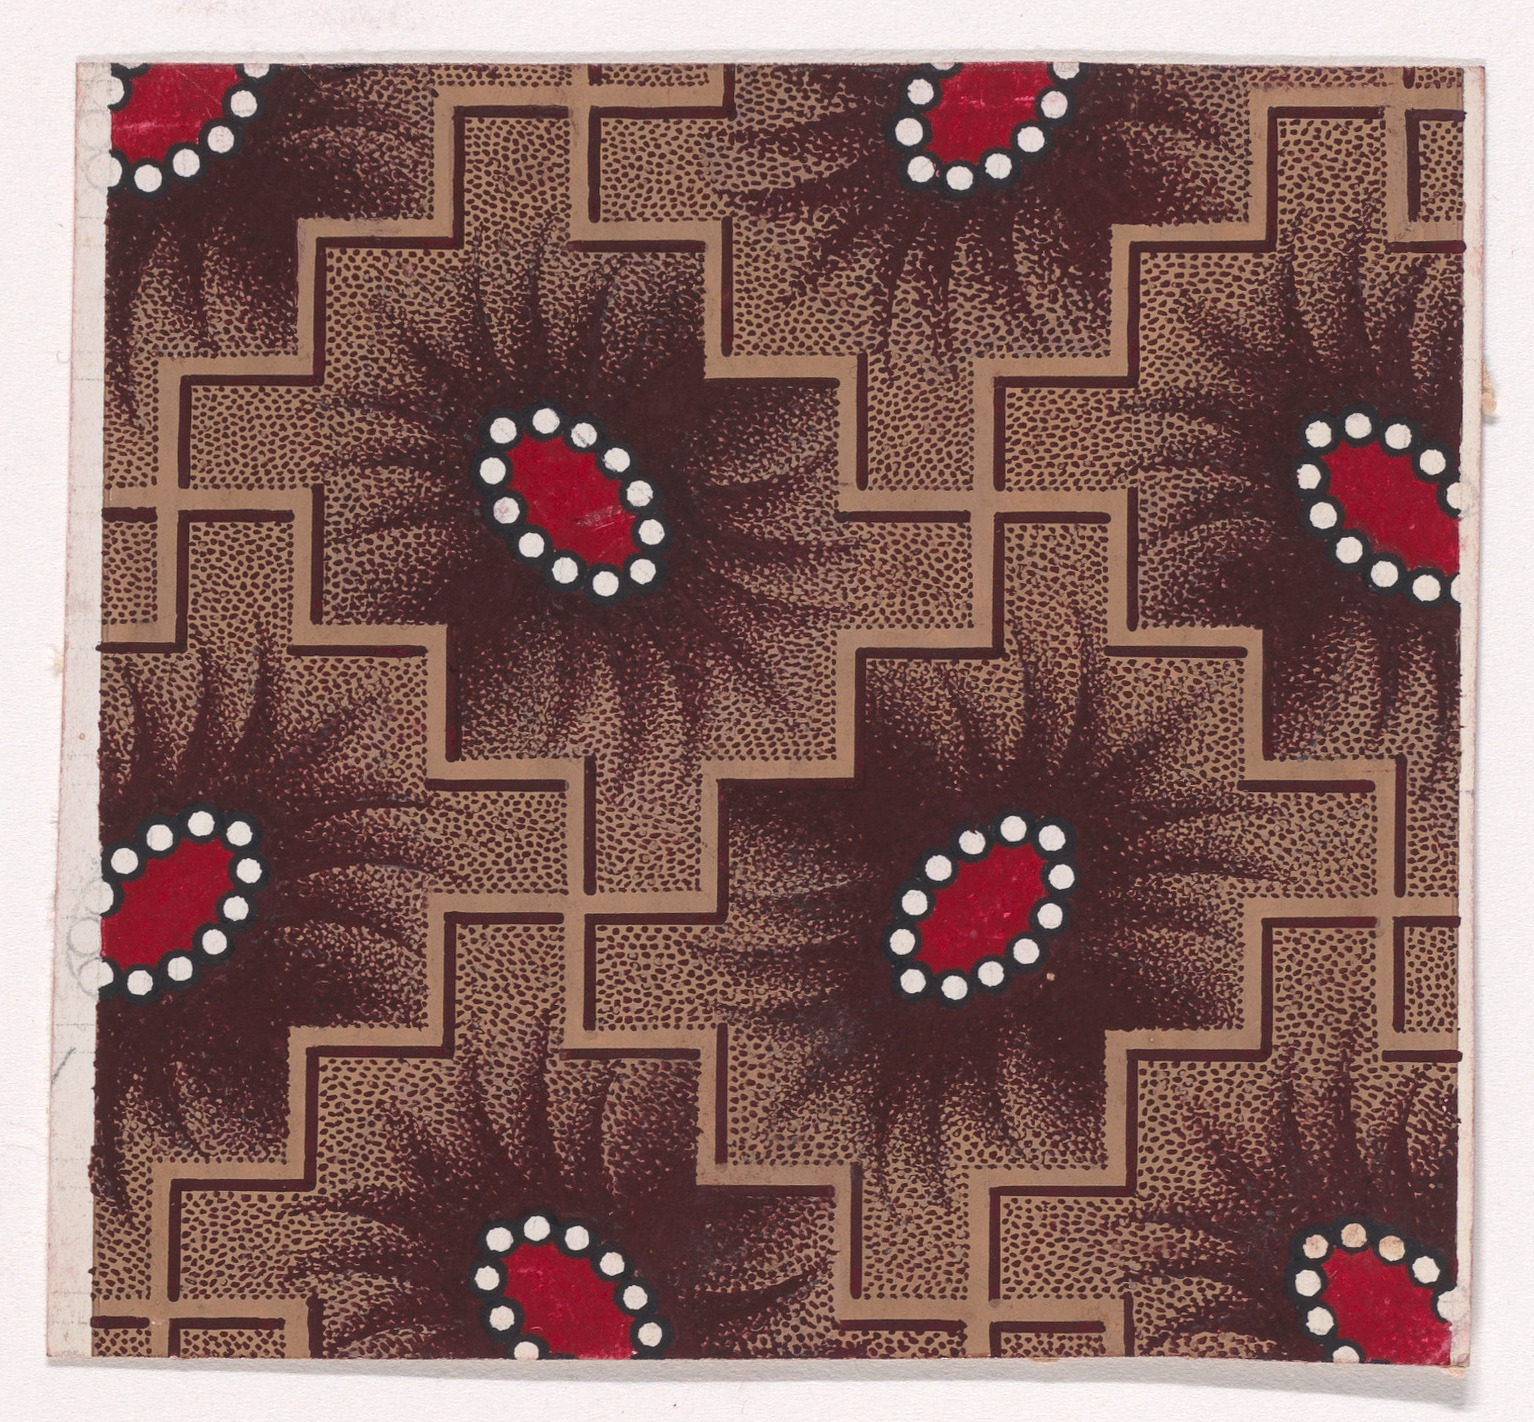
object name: drawing ornament architecture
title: Textile Design with Alternating Shuttle-Shaped Motifs Framed by Pearls and with Offsetting Palmettes Framed by a Checked Pattern of Intersecting Zig-Zagging Diagonal Lines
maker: anonymous, alsatian, 19th century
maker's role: artist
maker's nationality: alsatian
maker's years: 1800-1900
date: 1840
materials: gouache